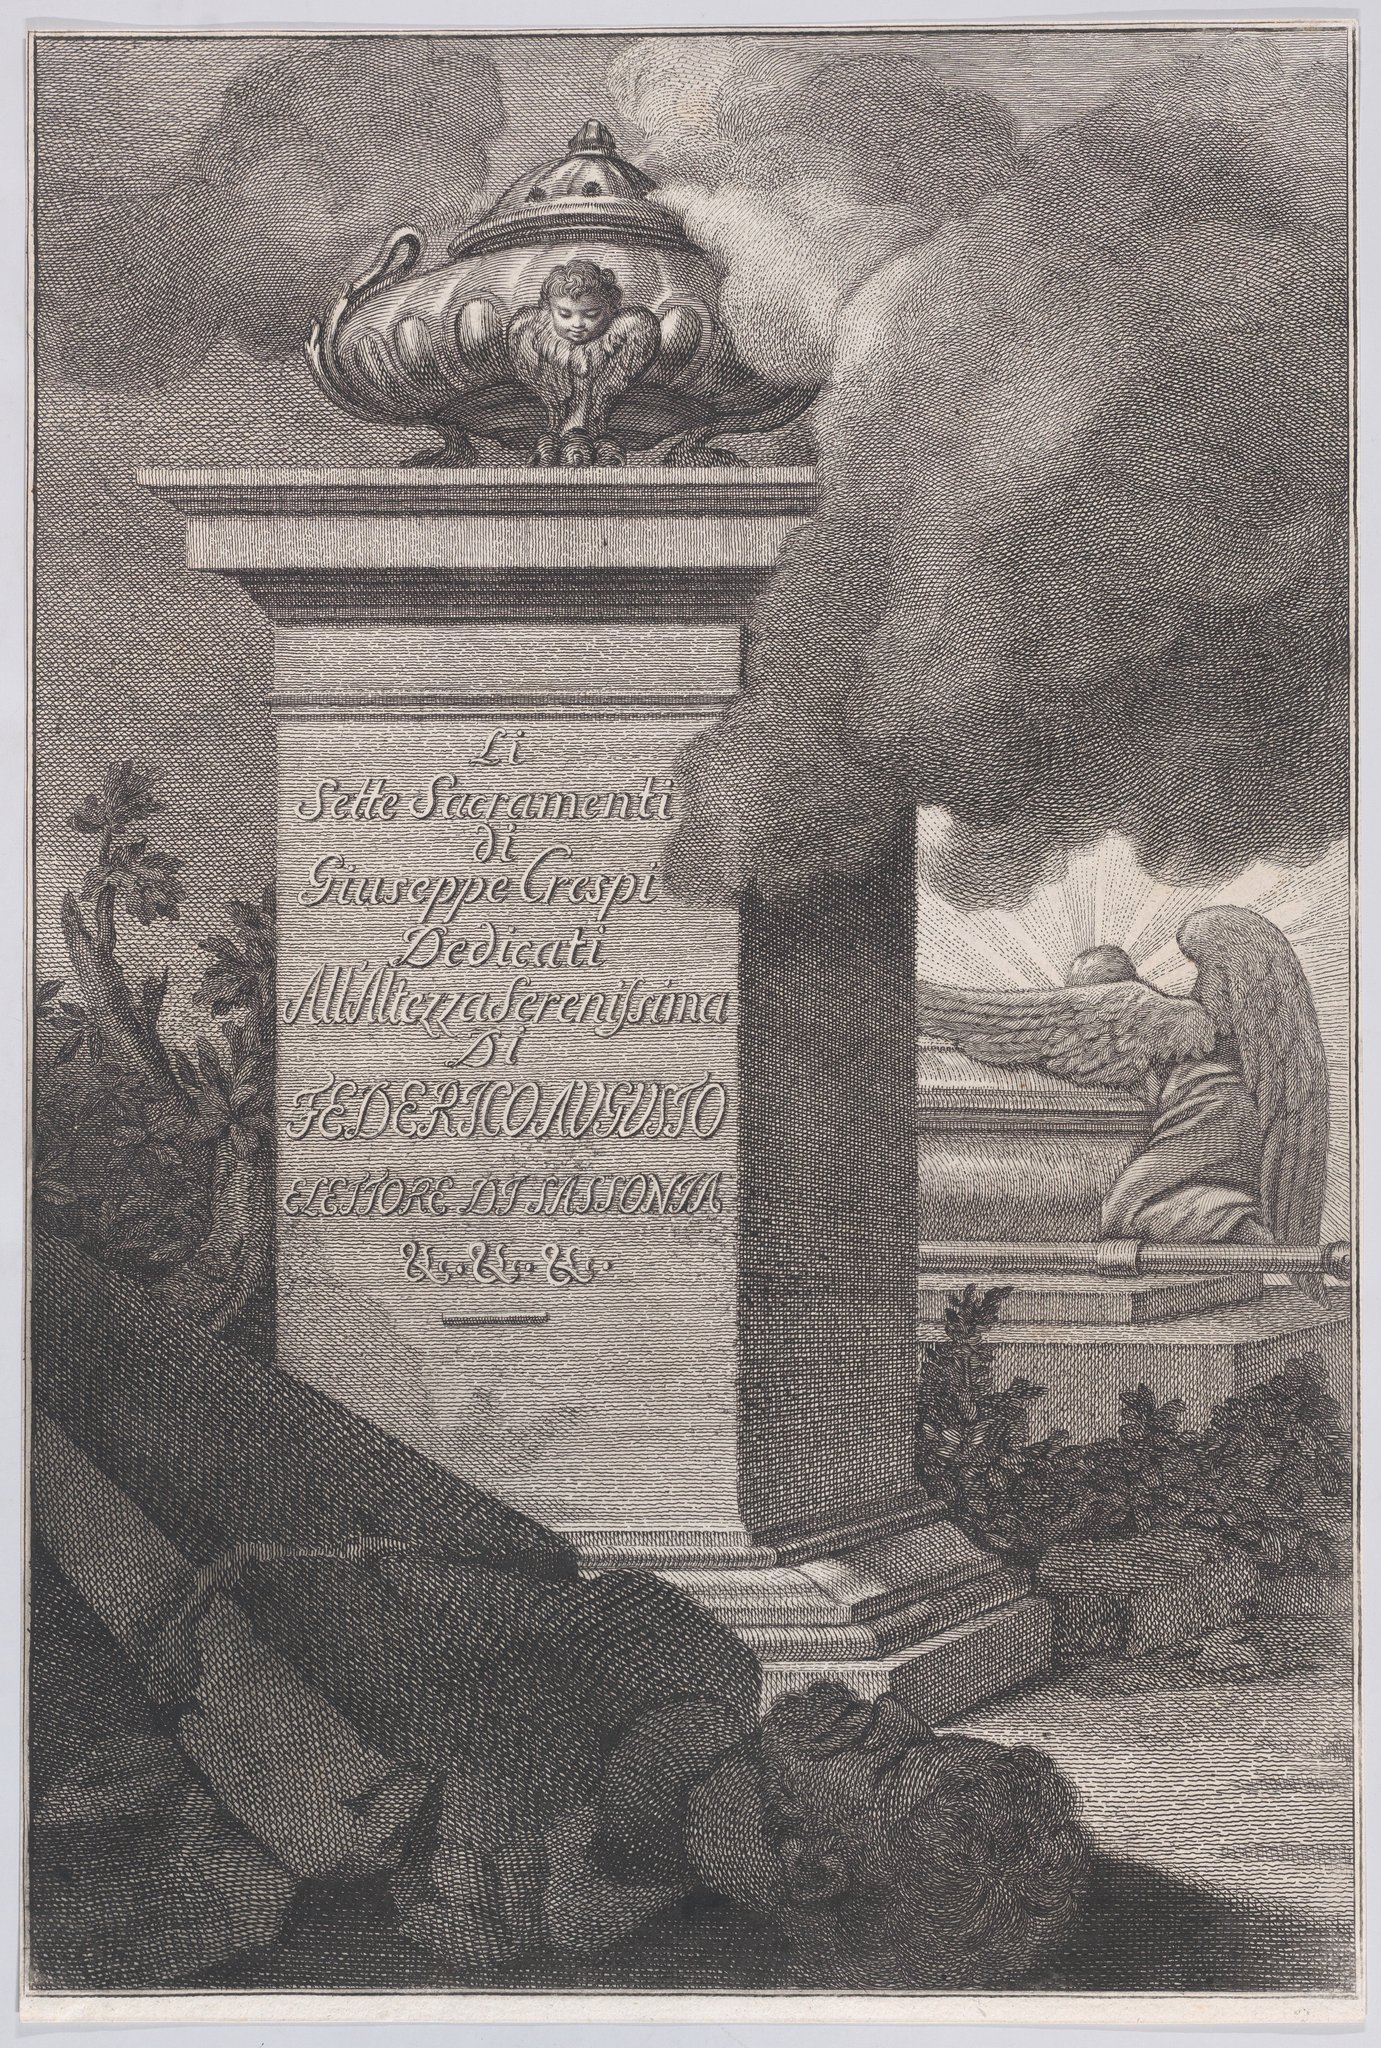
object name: print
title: Title page, from "The Seven Sacraments"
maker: lorenzo zucchi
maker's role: artist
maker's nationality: italian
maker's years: 1704-1779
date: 1767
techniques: etching